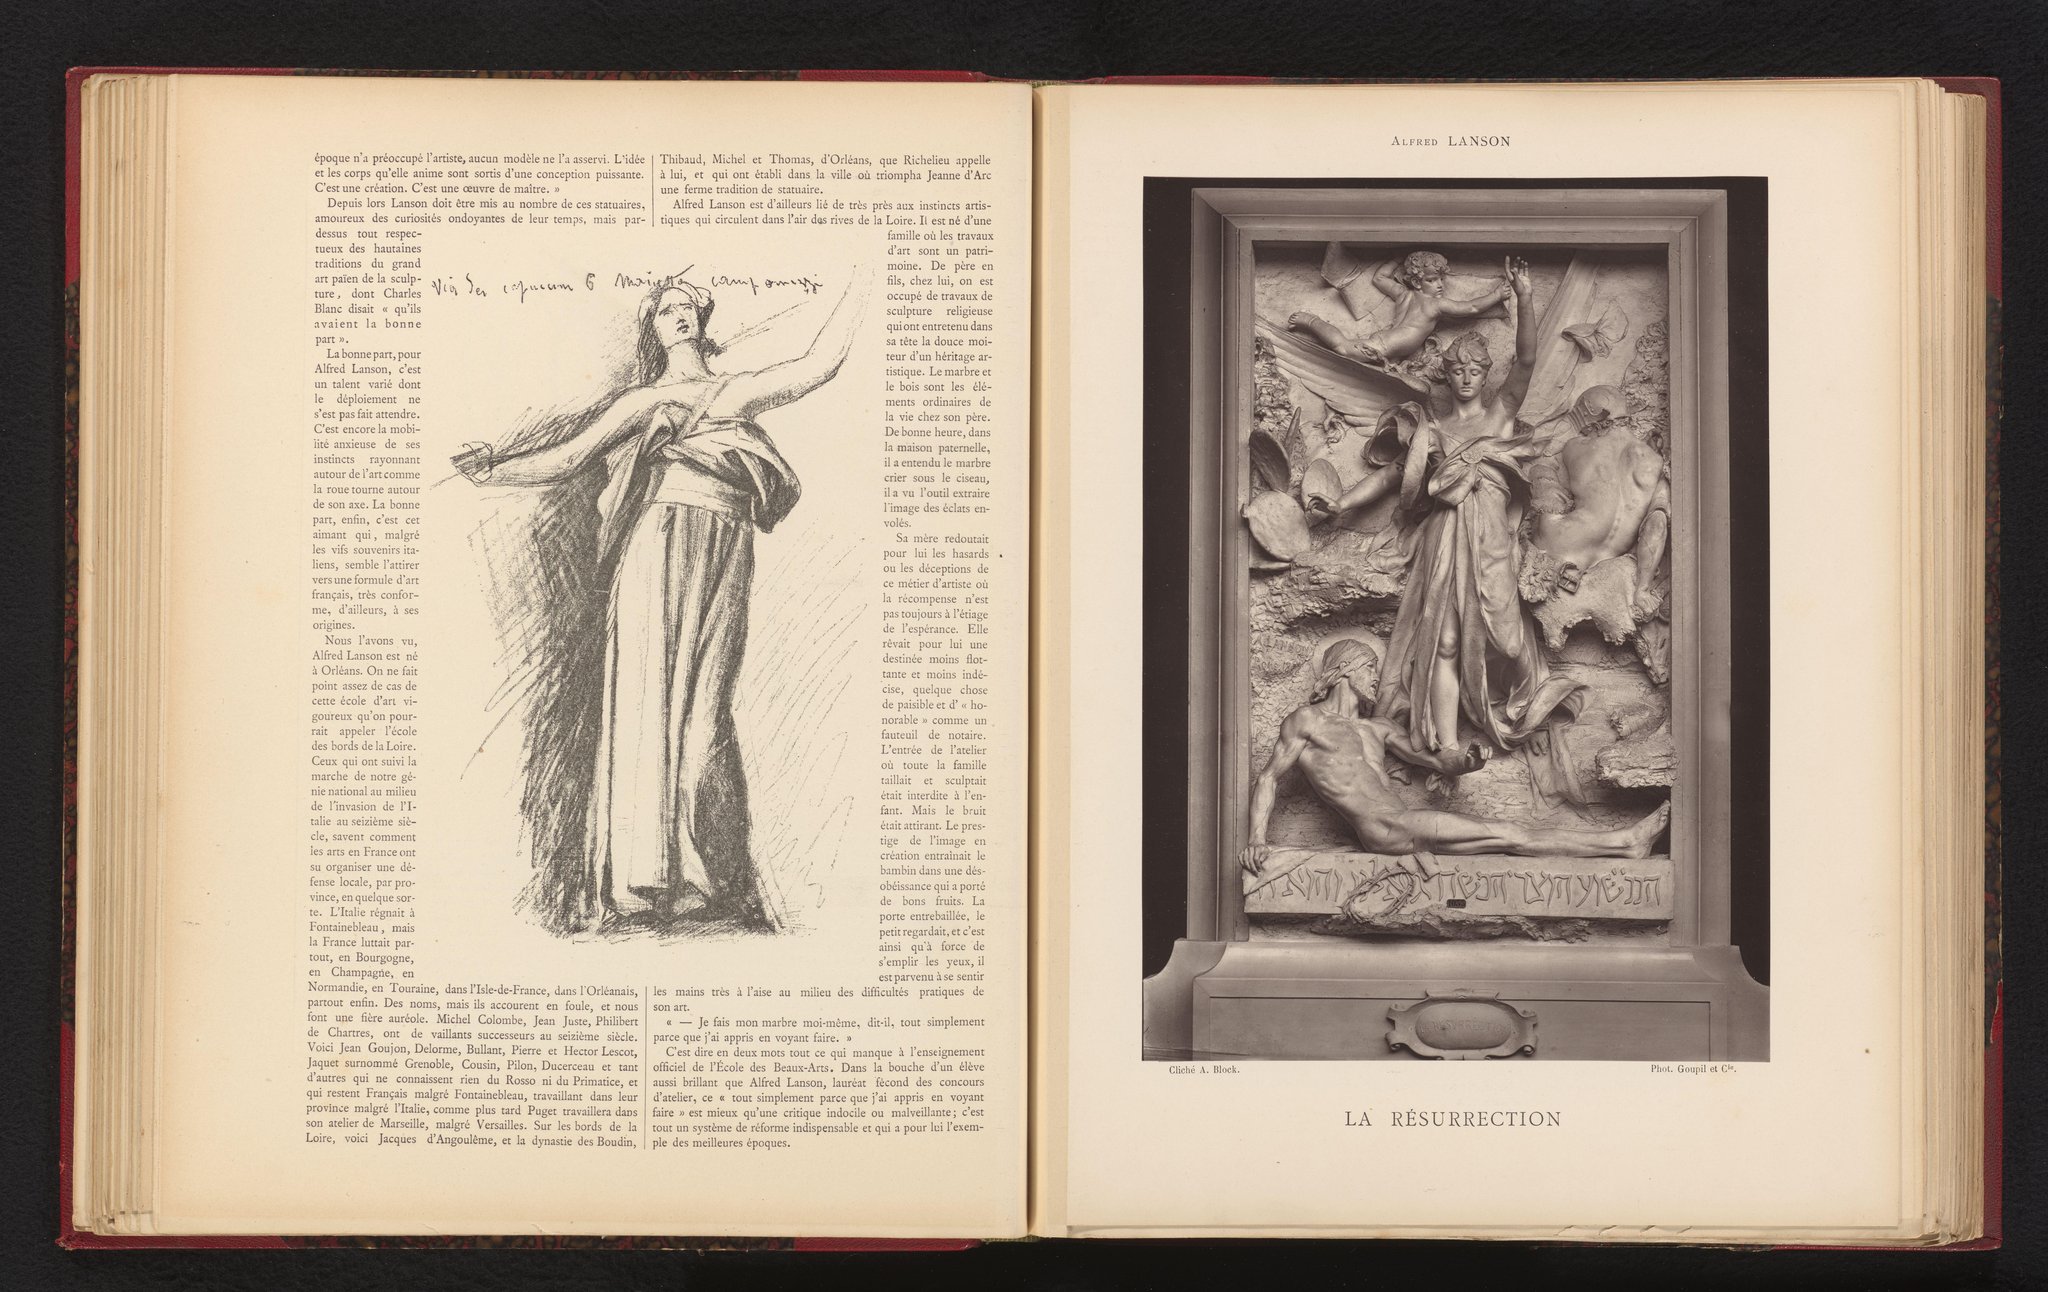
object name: photomechanical print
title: Sculptuur 'La résurrection' door Alfred-Désiré Lanson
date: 1879-1884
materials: paper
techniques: woodburytype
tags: resurrection of christ